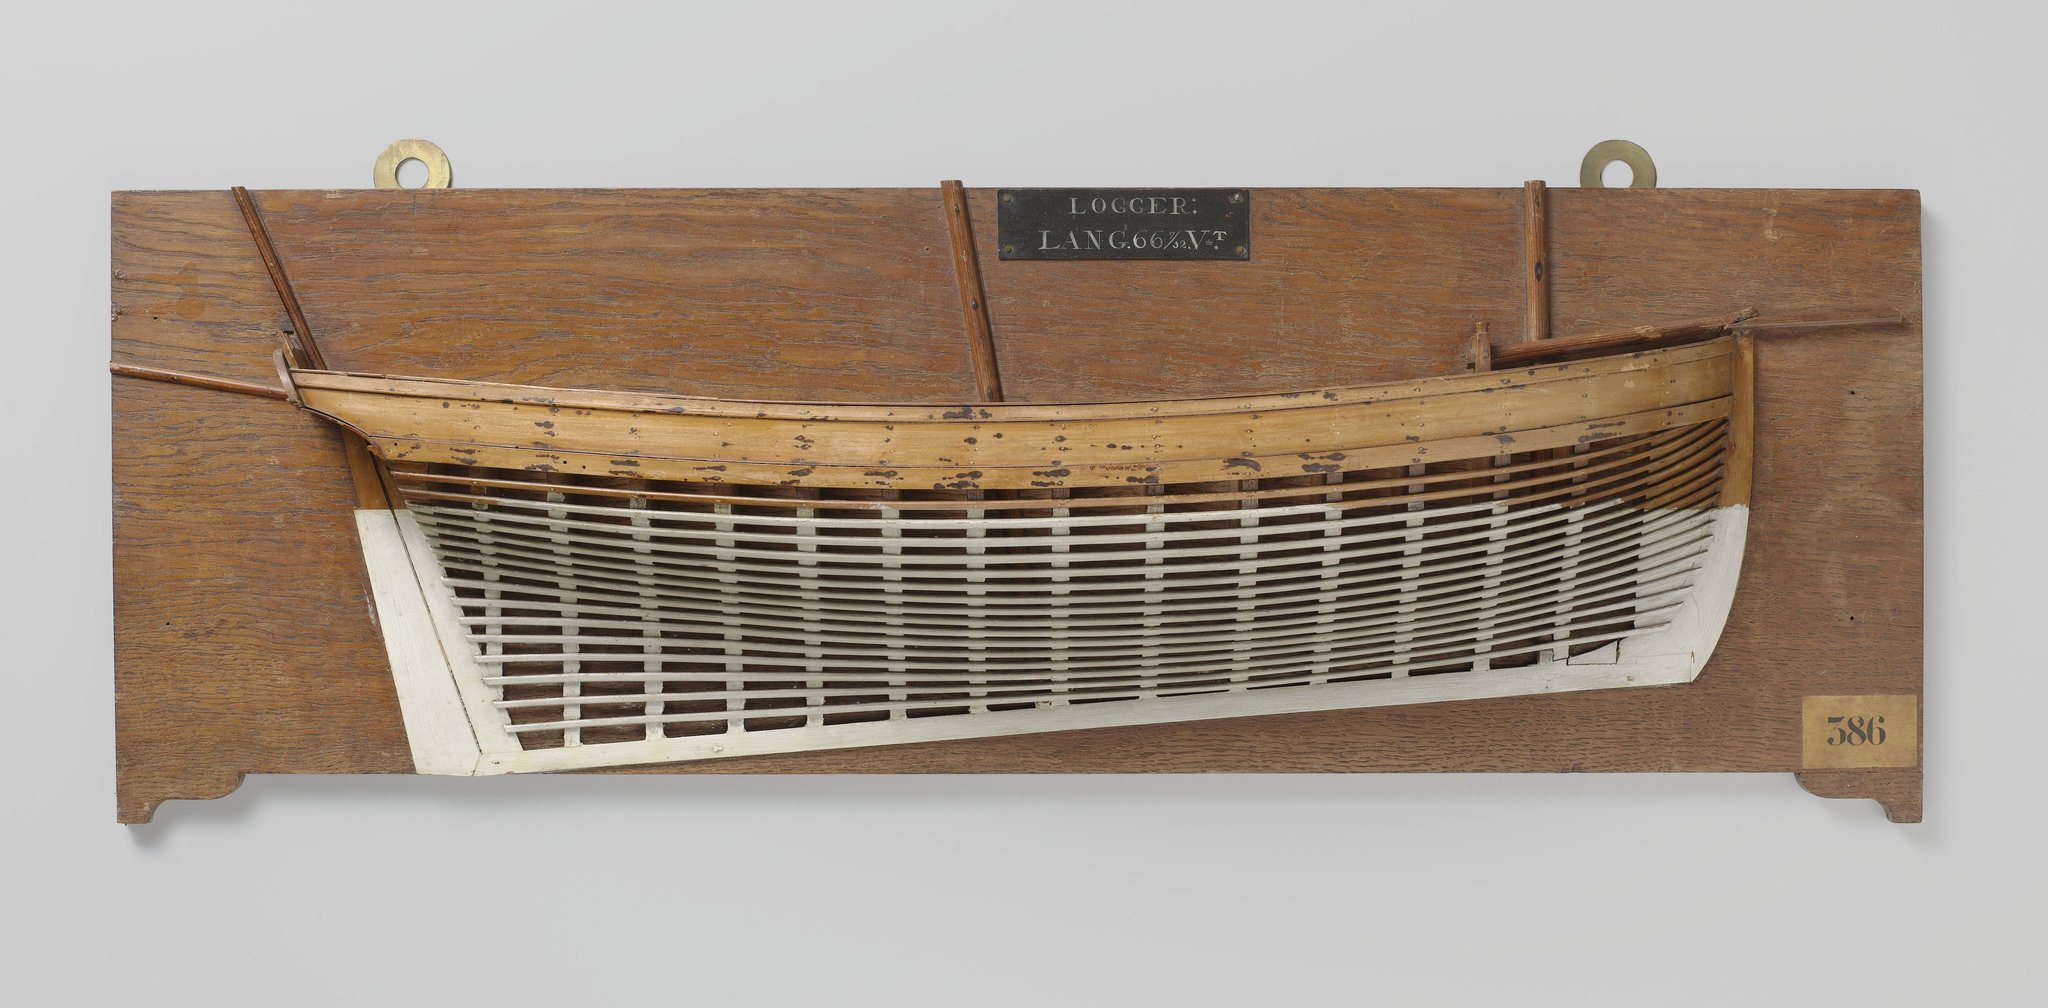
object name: half model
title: Half Model of a Lugger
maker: Anonymous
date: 1780-1810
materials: wood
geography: netherlands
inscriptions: label, bottom right: ‘386’ former inventory label, inscription, top centre, on a rectangular black label: ‘LOGGER: / LANG. 66 7/12 Vt.’